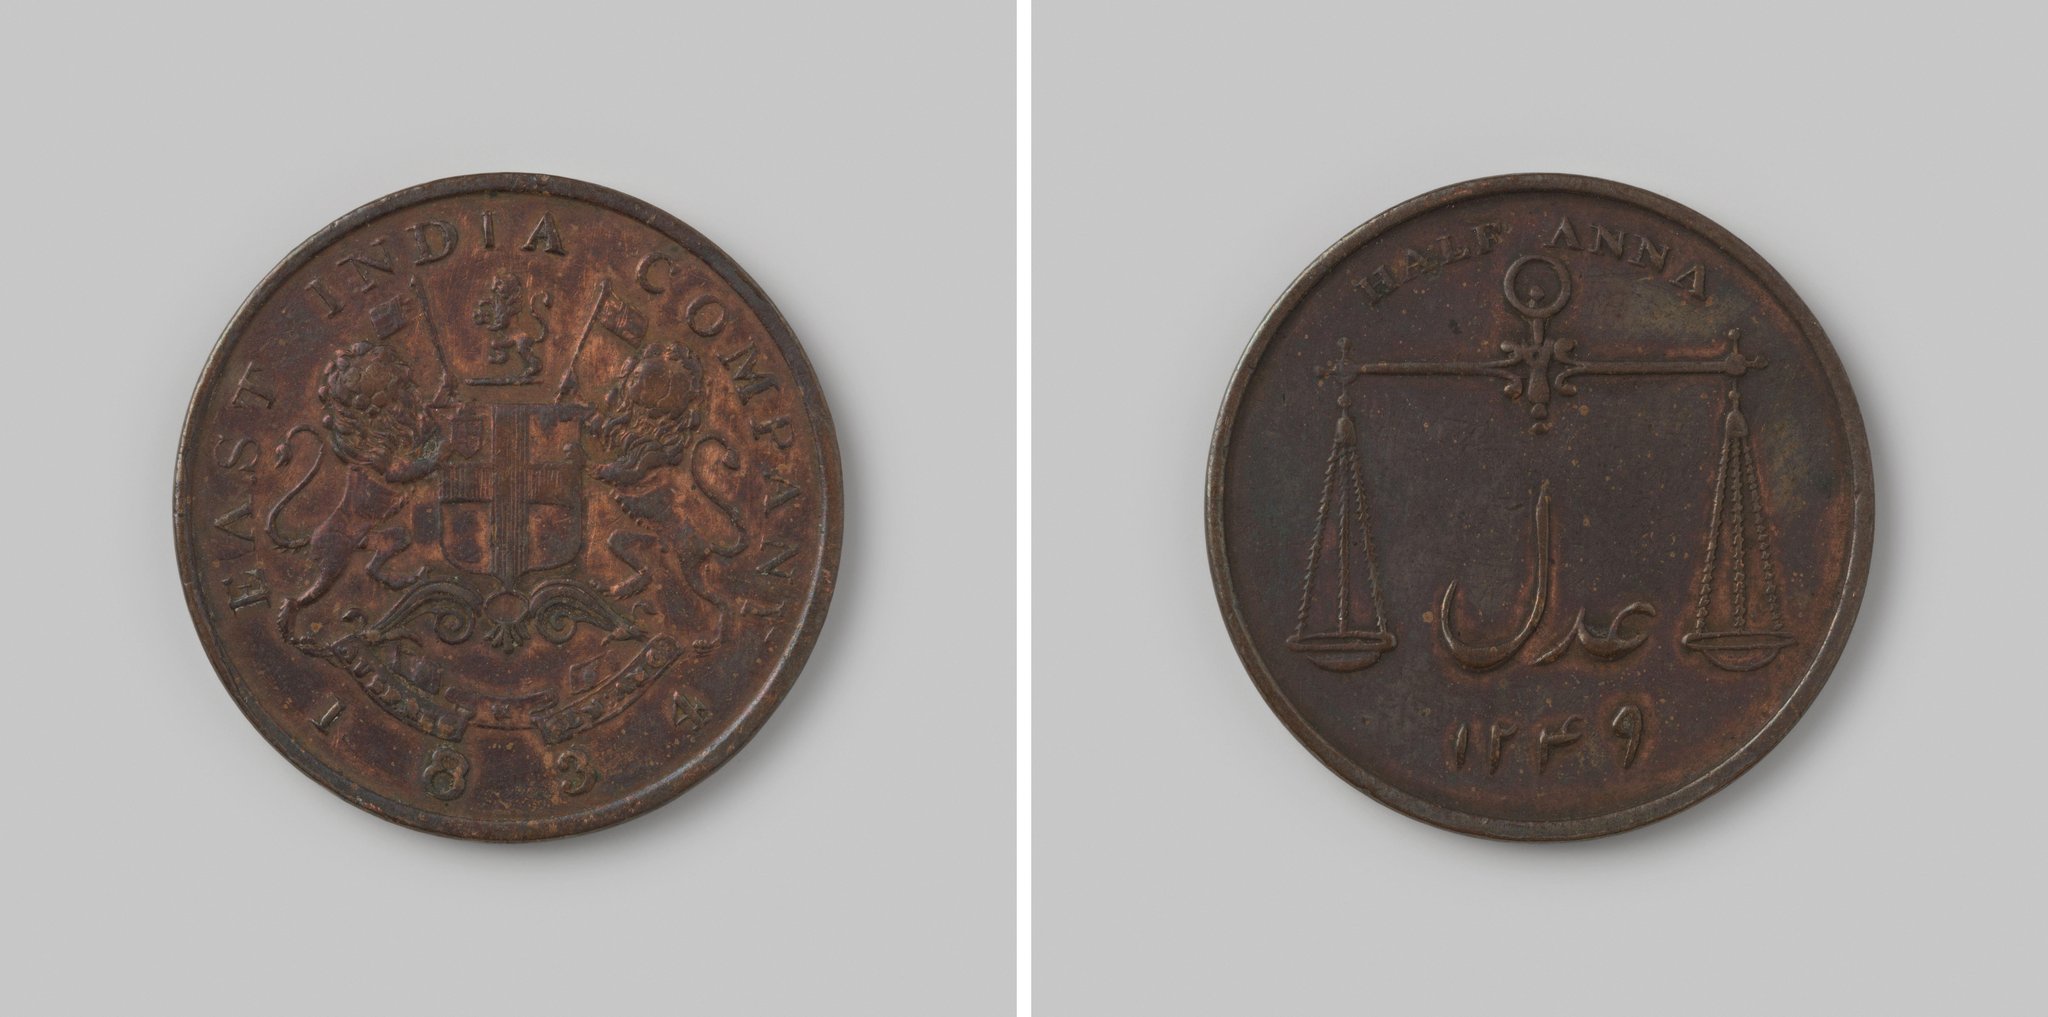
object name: coin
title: Bombay, India, Engelse Oostindische Compagnie (EIC) , ½ anna voor Bombay, India, 1834,1249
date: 1834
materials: copper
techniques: striking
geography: kolkata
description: Koperen munt. Voorzijde: door twee op versiering, waaronder geplooide banderol, waarin opschrift, staande leeuwen, met één klauw gehouden wapenschild van de EIC. Boven het weapenschild een helmteken. De leeuwen houden in de andere klauw een pijl, waaraan vlag. Jaartal onderaan. Keerzijde: weegschaal, waartussen in Arabische lettertekens opschrift: Adil. Bovenaan waarde-aanduiding: half anna en en onderaan jaartal: 1249. Gladde rand.